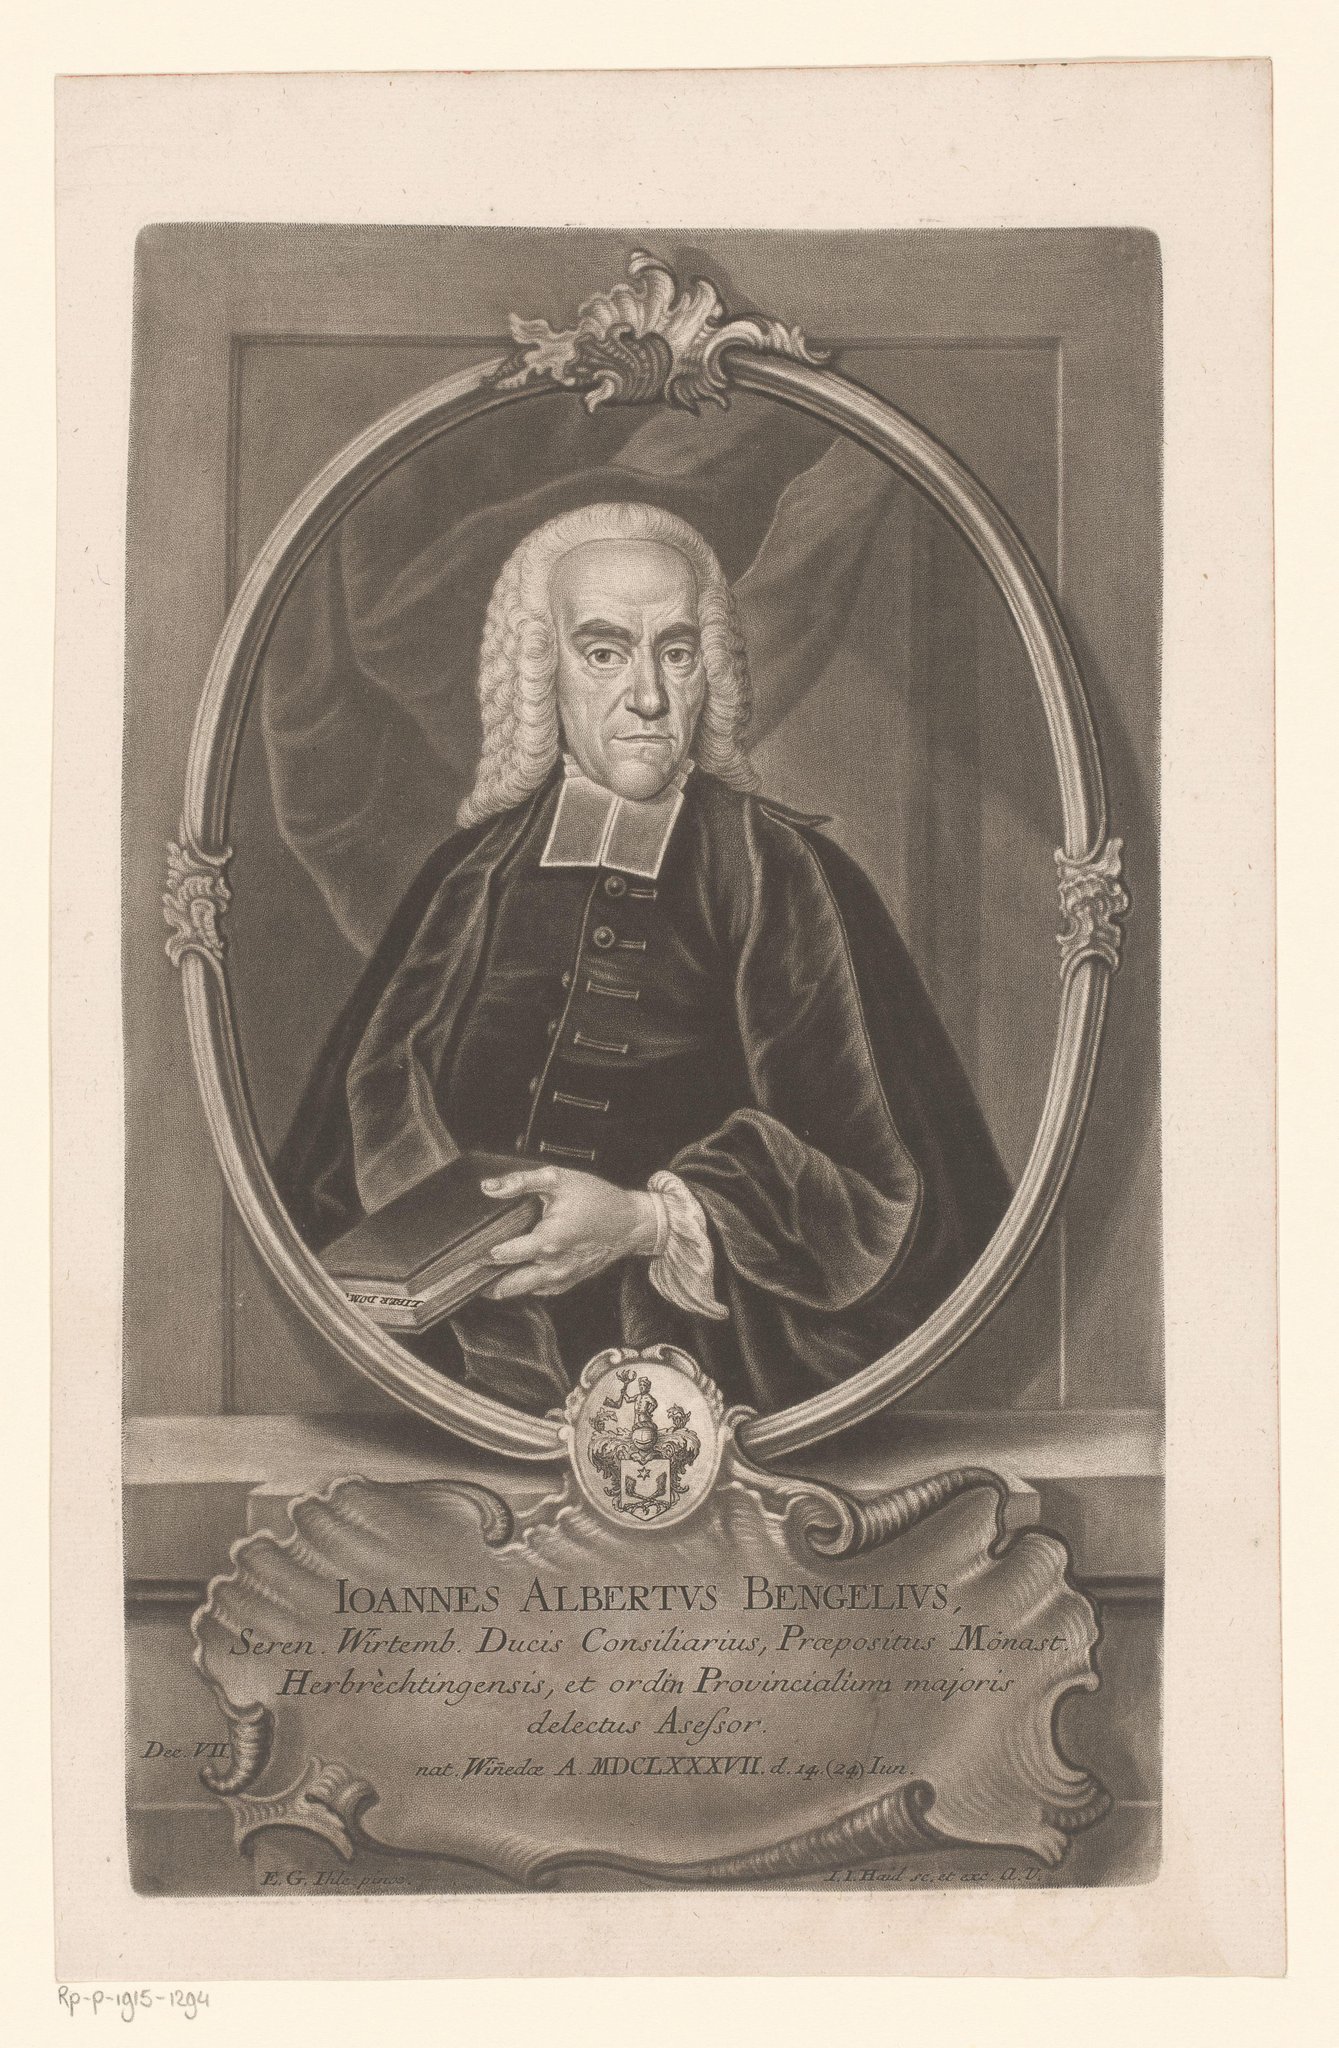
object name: print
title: Portret van Johann Albrecht Bengel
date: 1748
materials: paper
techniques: etching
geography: augsburg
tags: rocaille ornament, historical persons, book, armorial bearing, heraldry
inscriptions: collector's mark: Lugt 2228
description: Prent gebruikt voor: Brucker, Jacob. Bildersal heutiges Tages lebender und durch Gelahrtheit berühmter Schrifftsteller. Augsburg: Johann Jacob Haid, 1748.